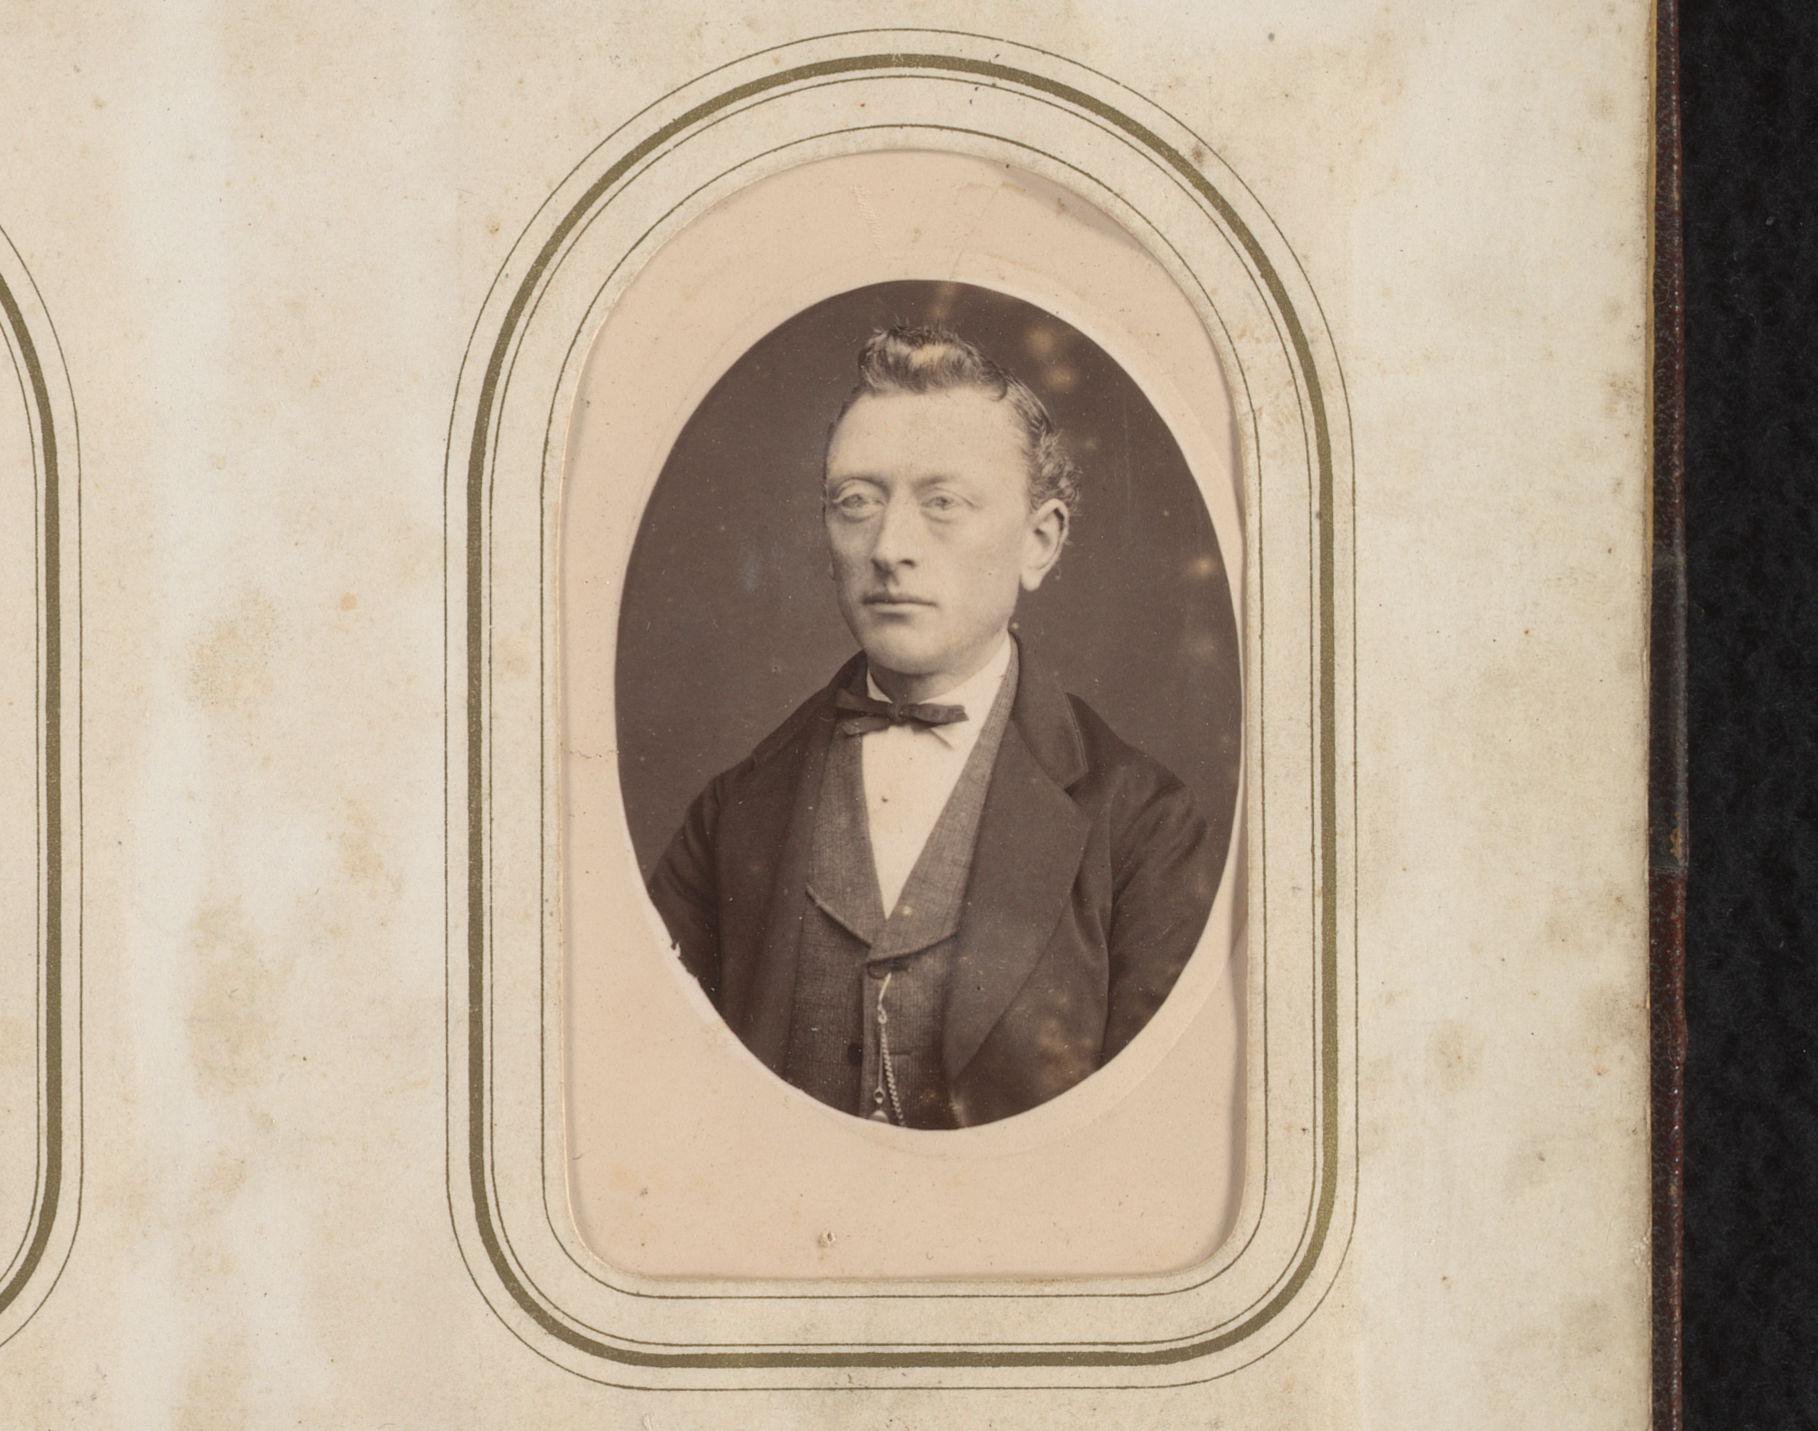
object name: semi enamel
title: Portret van een man met vlinderstrik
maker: willem gerhardus kuijer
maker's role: fotograaf, hoffotograaf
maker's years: 1834-1899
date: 1862-1899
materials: cardboard, celluloid, photographic support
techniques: albumen print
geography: amsterdam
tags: historical persons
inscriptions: inscription: ‘W. G. KUIJER/ Photograaph/ Amsterdam/ Rozengracht 72.’